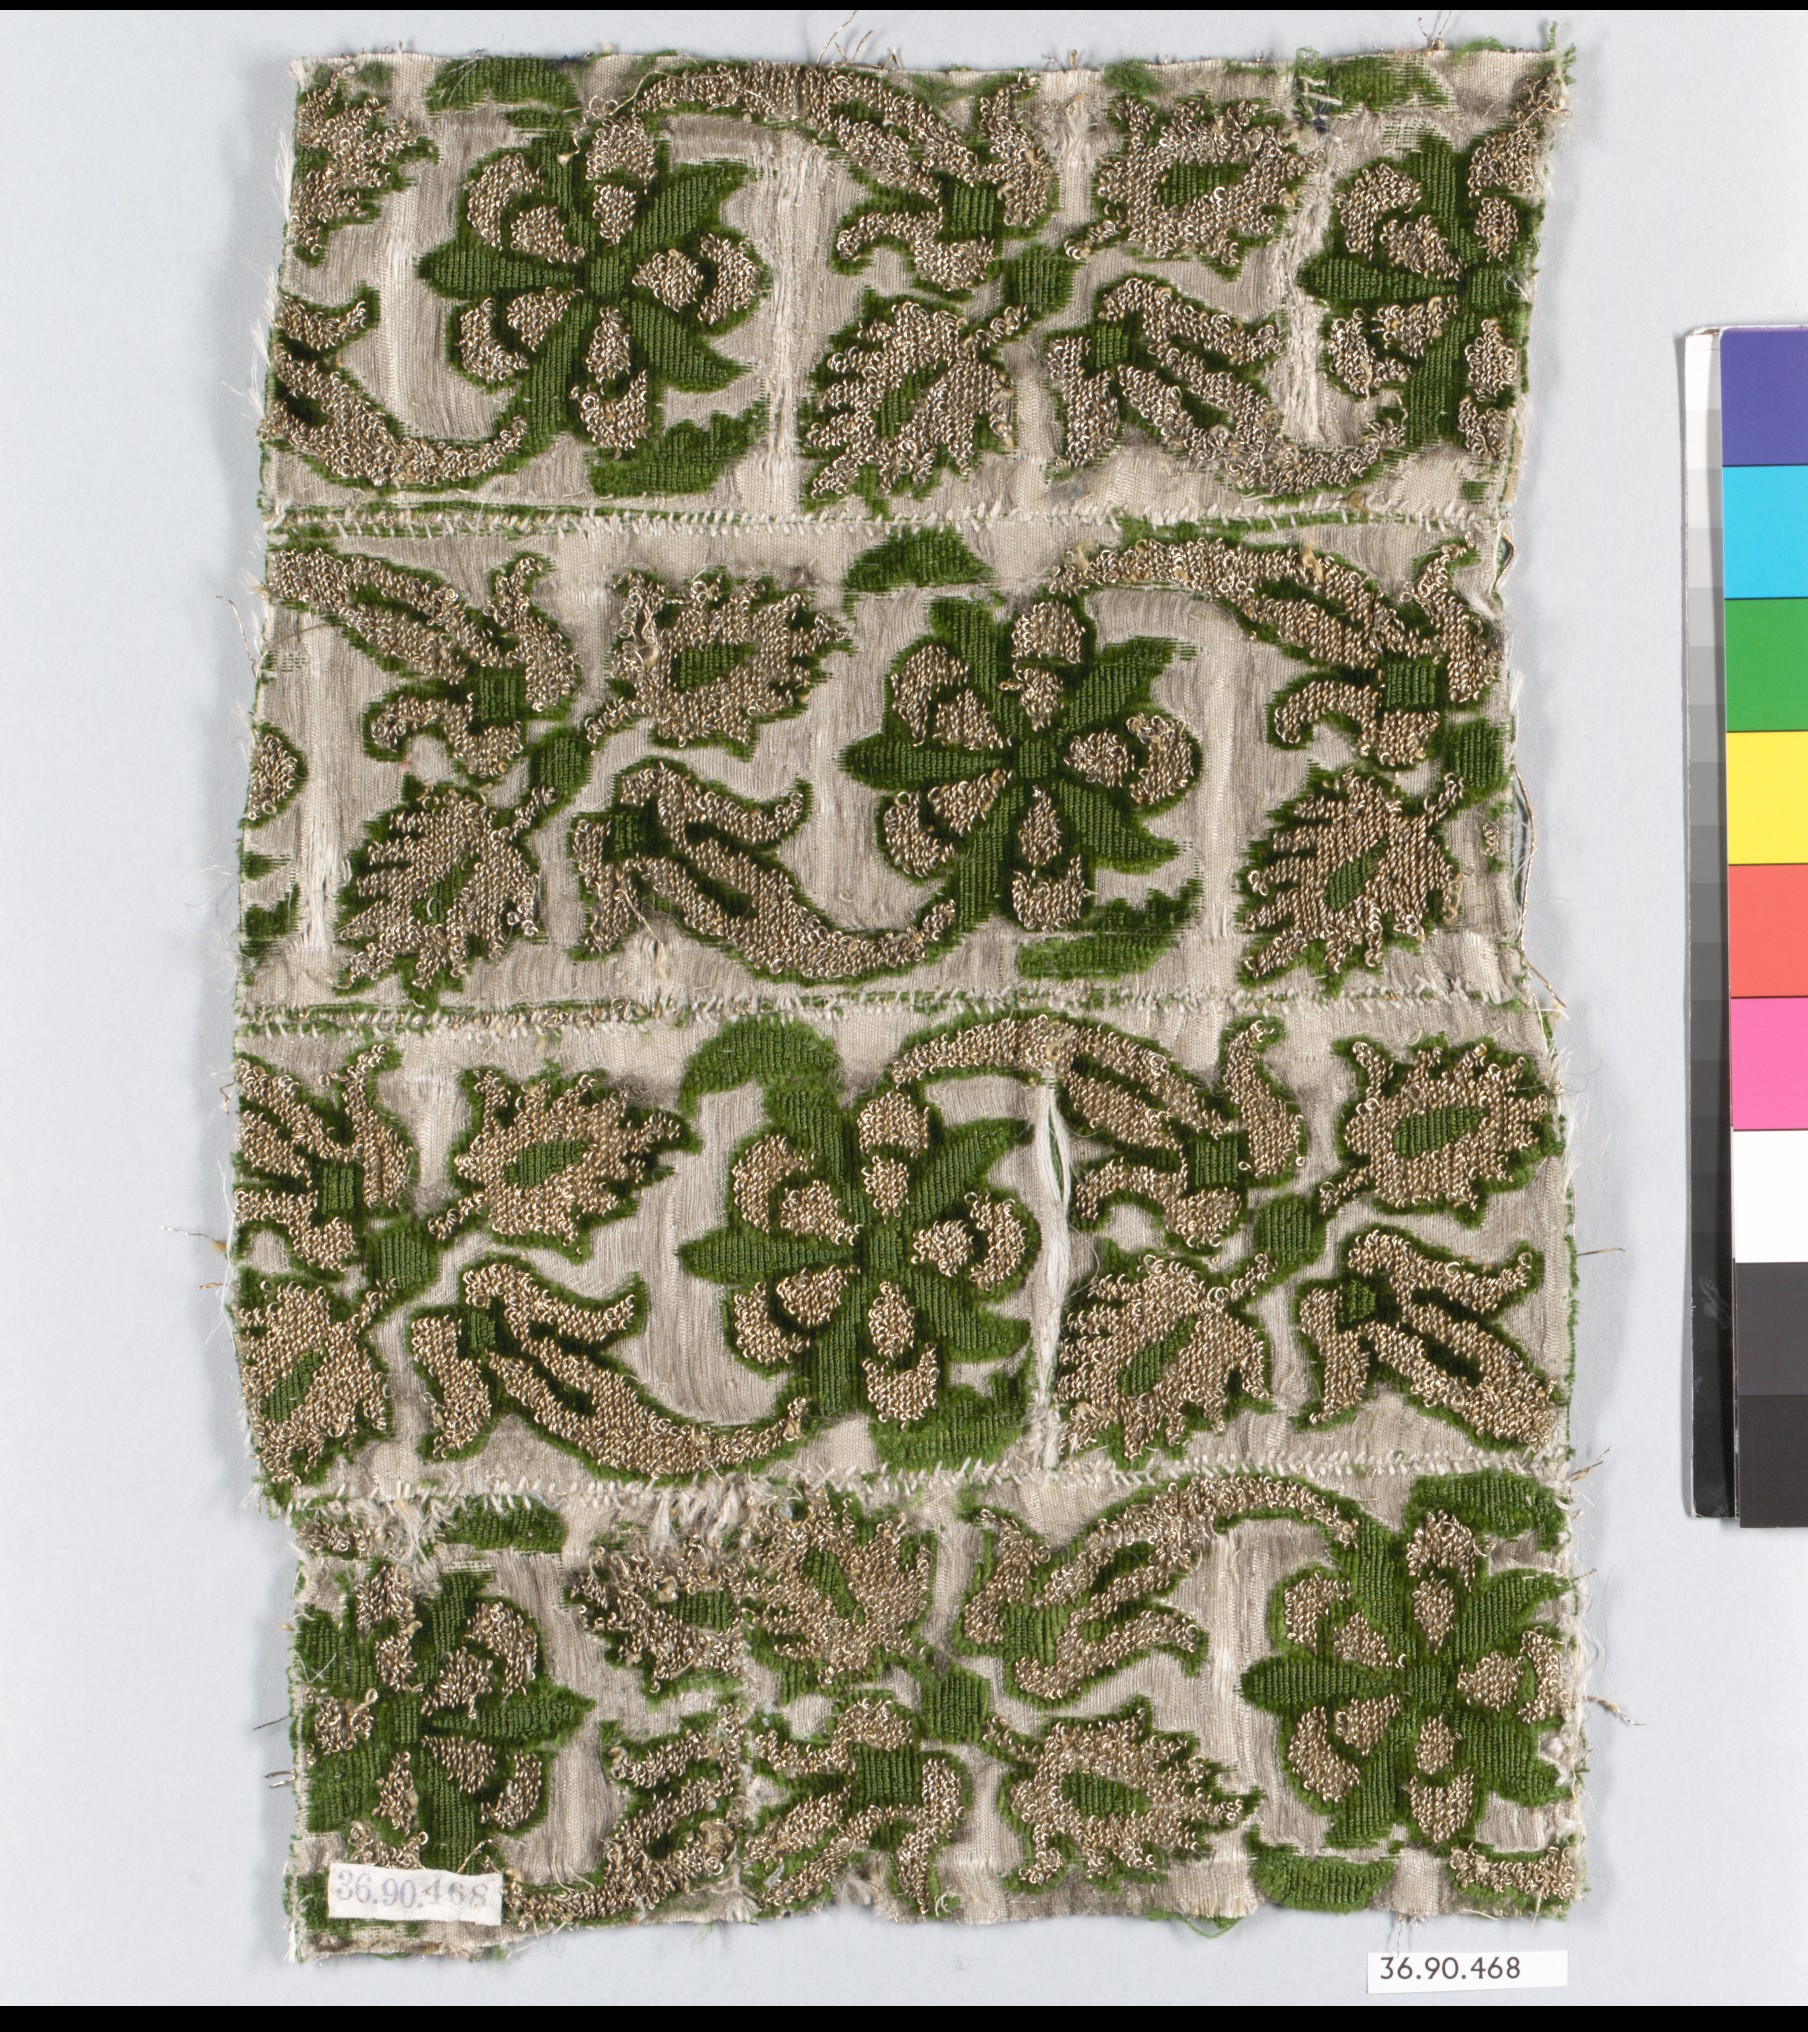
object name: piece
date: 1501-1700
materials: metal thread, silk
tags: flowers,leaves